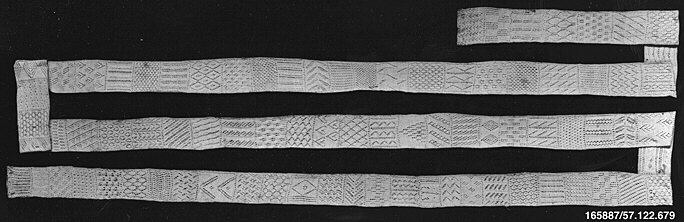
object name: sampler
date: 1801-1900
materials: lace, wool